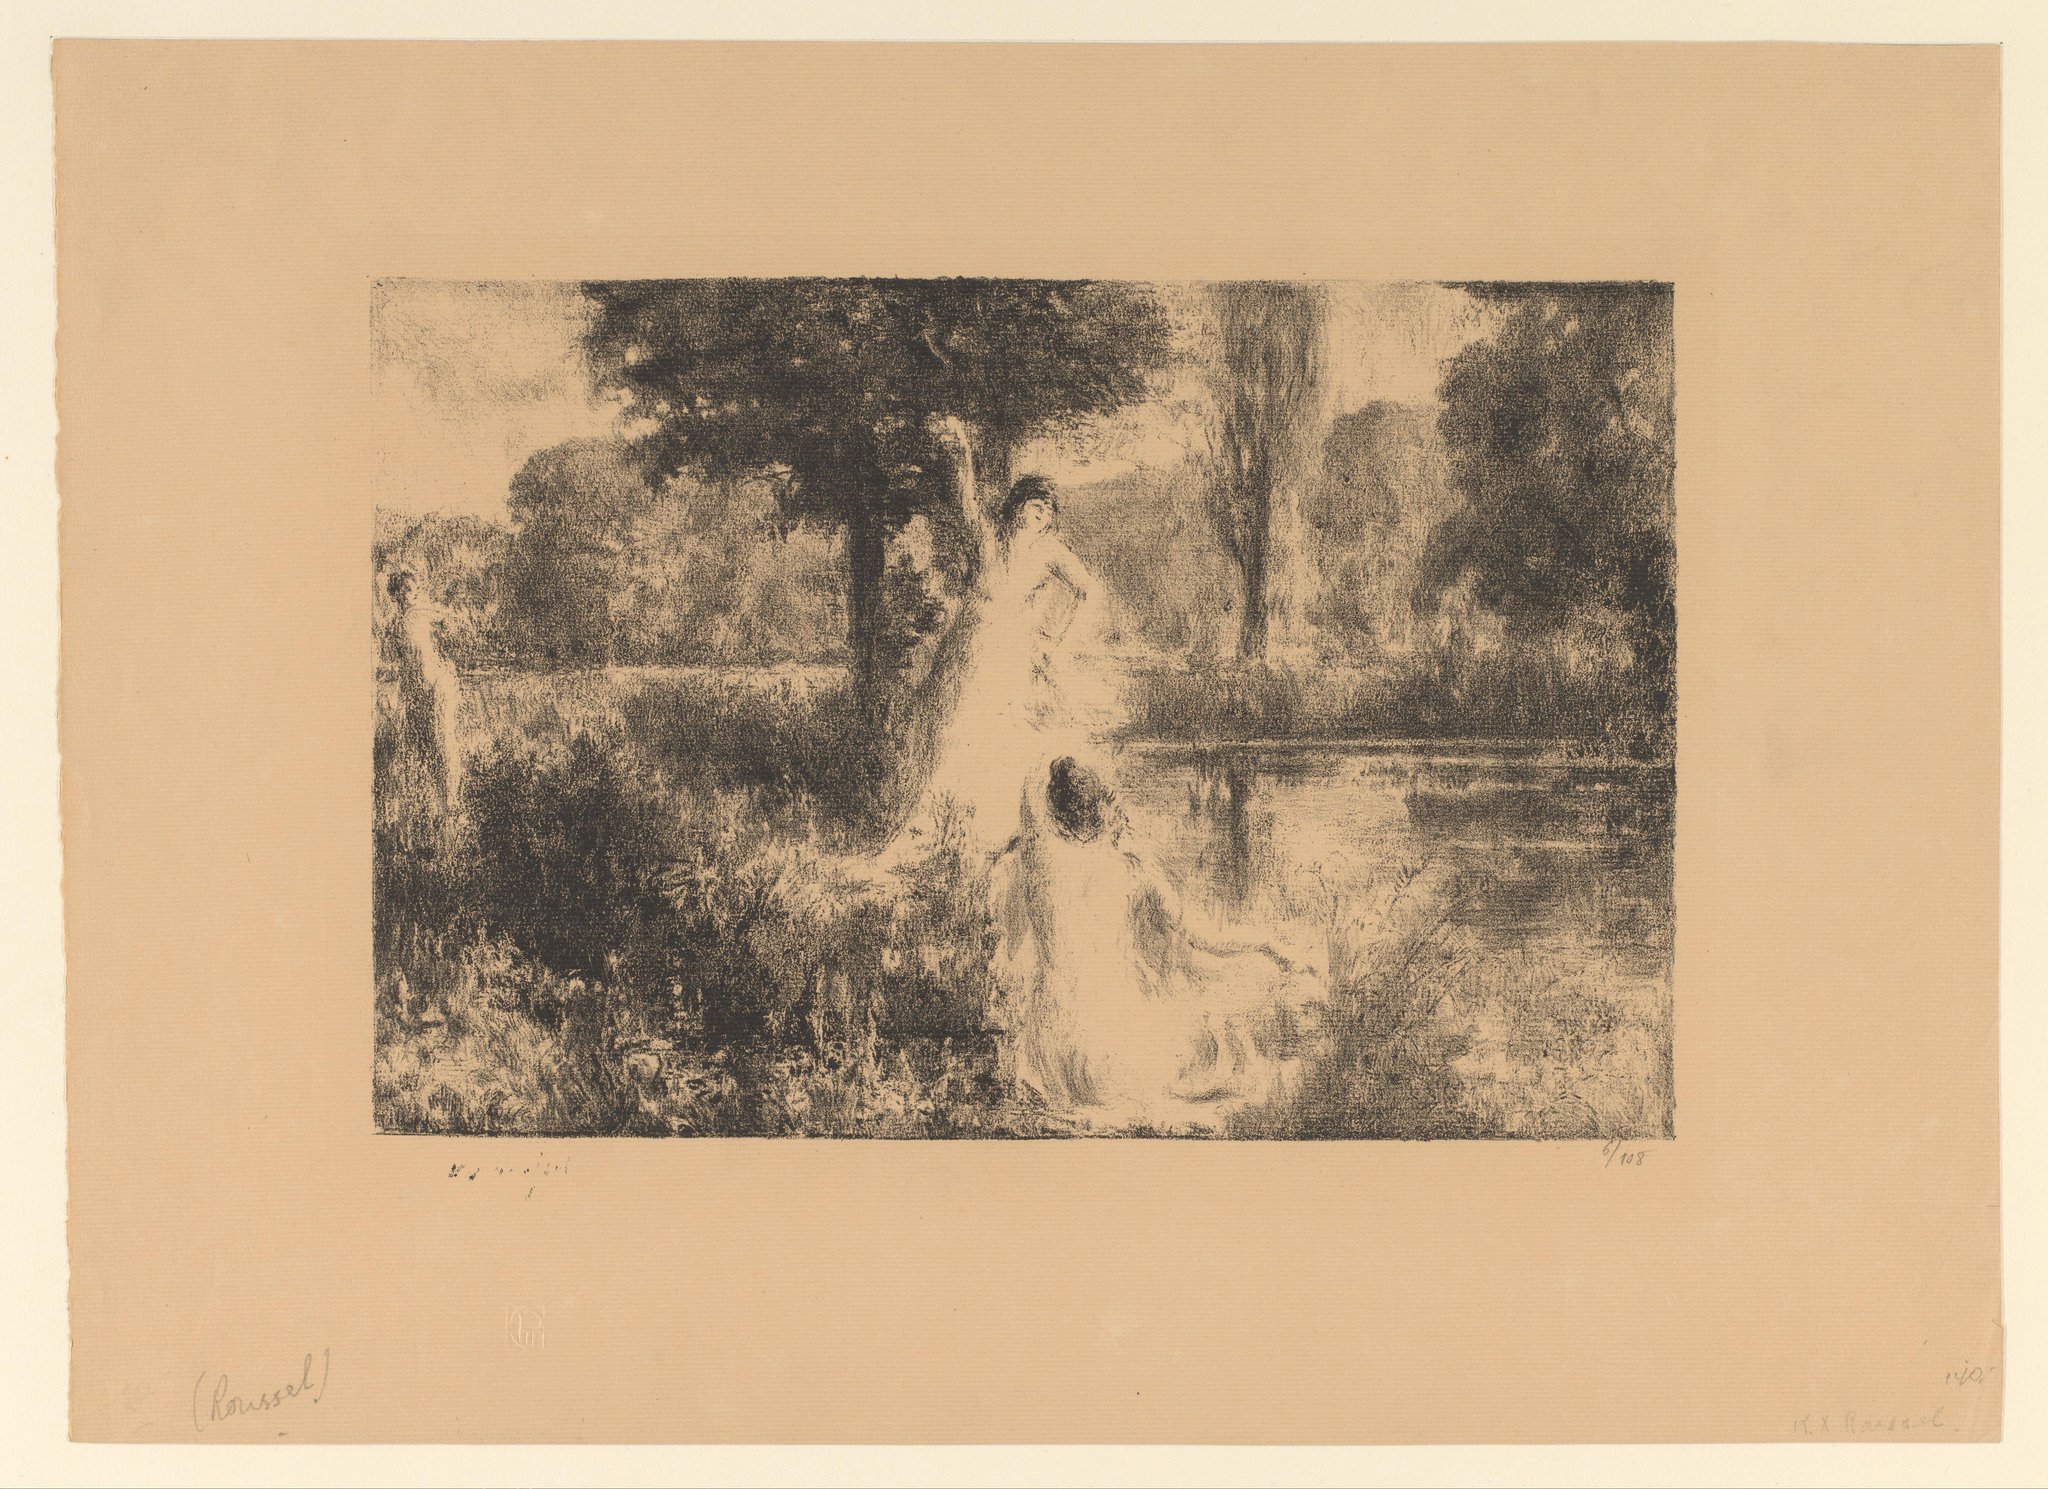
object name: print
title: Drie vrouwen aan de waterkant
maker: ker xavier roussel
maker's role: draughtsman, print maker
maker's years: 1867-1944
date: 1920-1935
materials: paper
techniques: lithograph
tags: lake, adult woman (+ two persons)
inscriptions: collector's mark: Lugt 2760, inscription: ‘140.-’, collector's mark: Lugt 2228, check stamp: Lugt 1195a, signature: ‘K. X Roussel.’